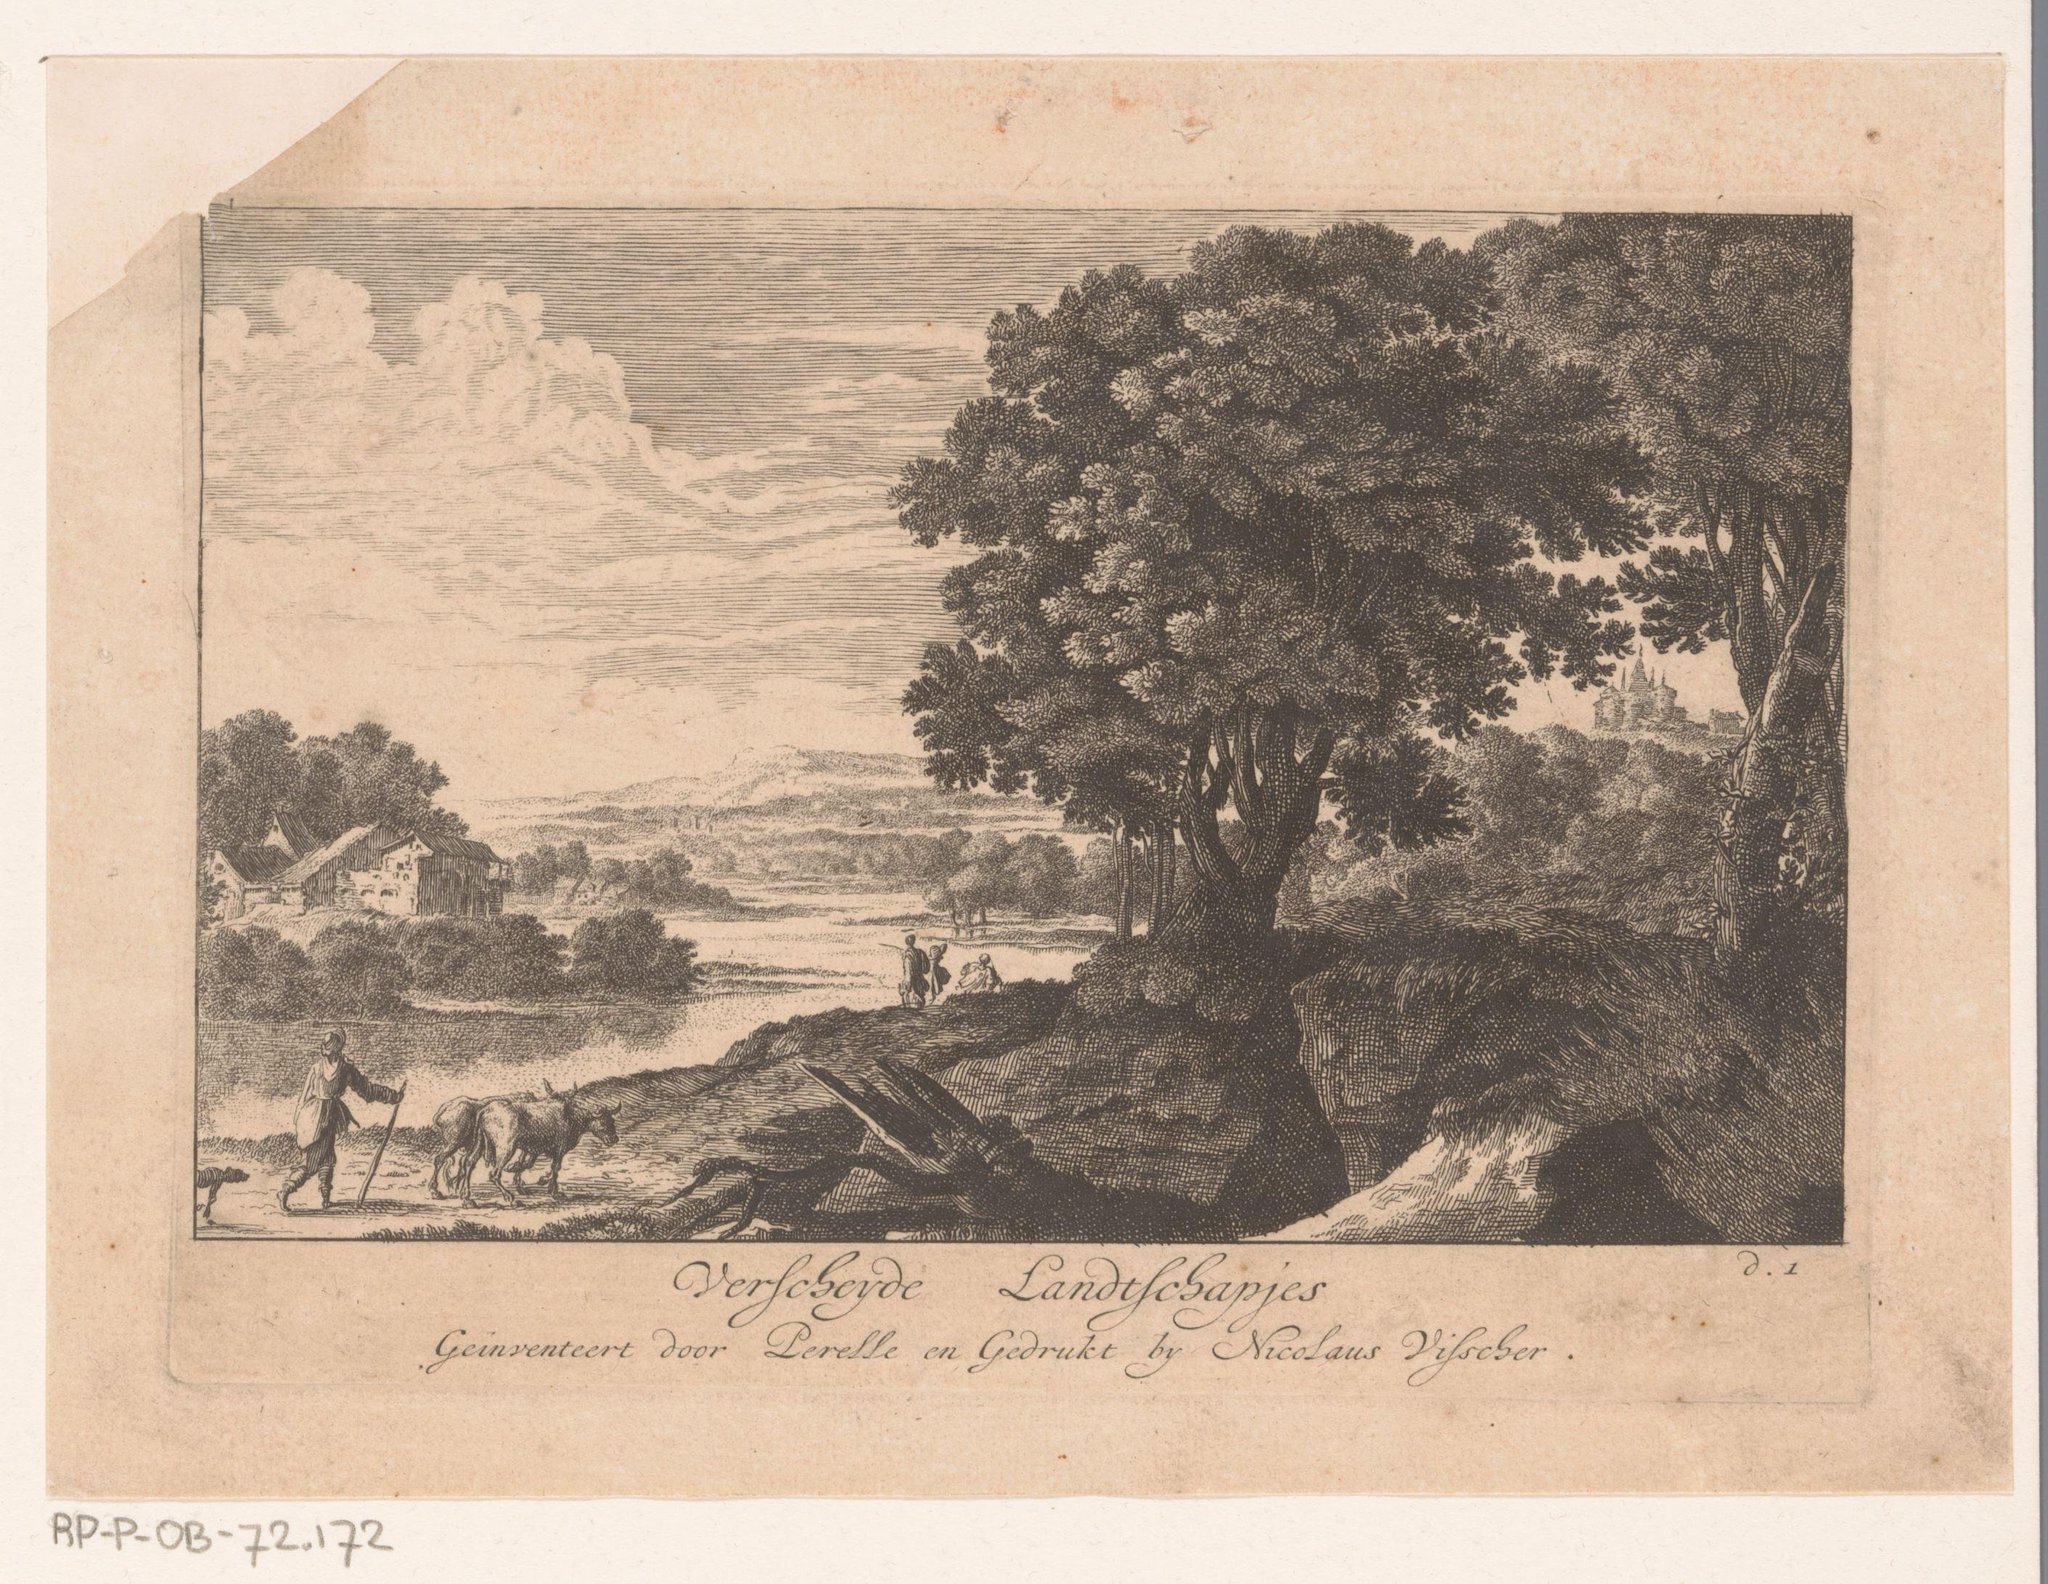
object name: print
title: Verscheyde Landtschapjes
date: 1628-1679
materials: paper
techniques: etching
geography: amsterdam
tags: landscapes with waters, waterscapes, seascapes (in the temperate zone)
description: Prenten met het signatuur 'Perelle' kunnen zowel door vader Gabriel als door zonen Nicolas en Adam gemaakt zijn.